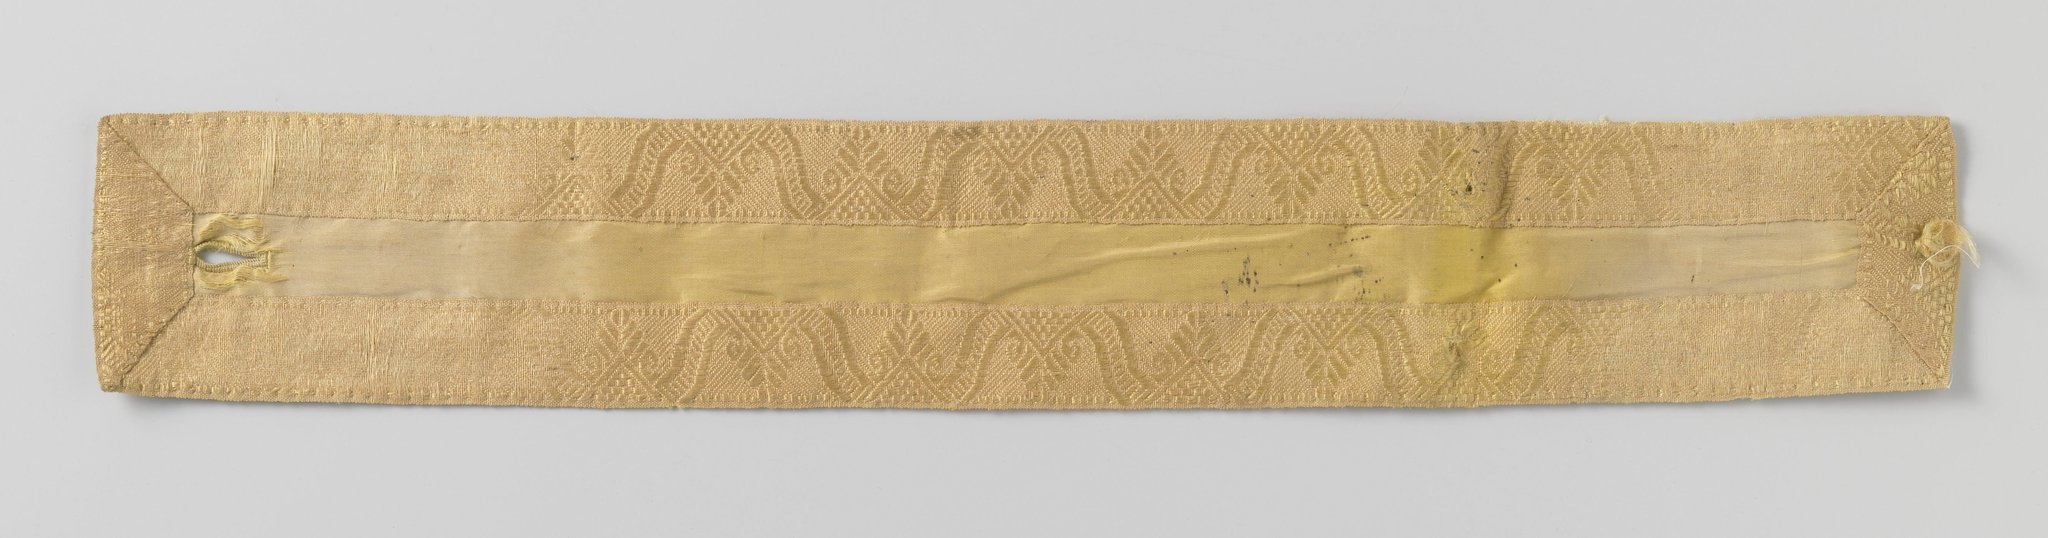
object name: tieback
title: Embrasse van geel zijde, omboord met passement met palmetten en een gebogen lint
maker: Anonymous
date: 1790-1846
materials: silk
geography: northern netherlands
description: Geel zijden embrasse omboord met passement met palmetten en een gebogen lint, gevoerd met gele zijde; met een knoopsgat en een knoop. Horend bij inv.nr. BK 1980-776a,b,d.